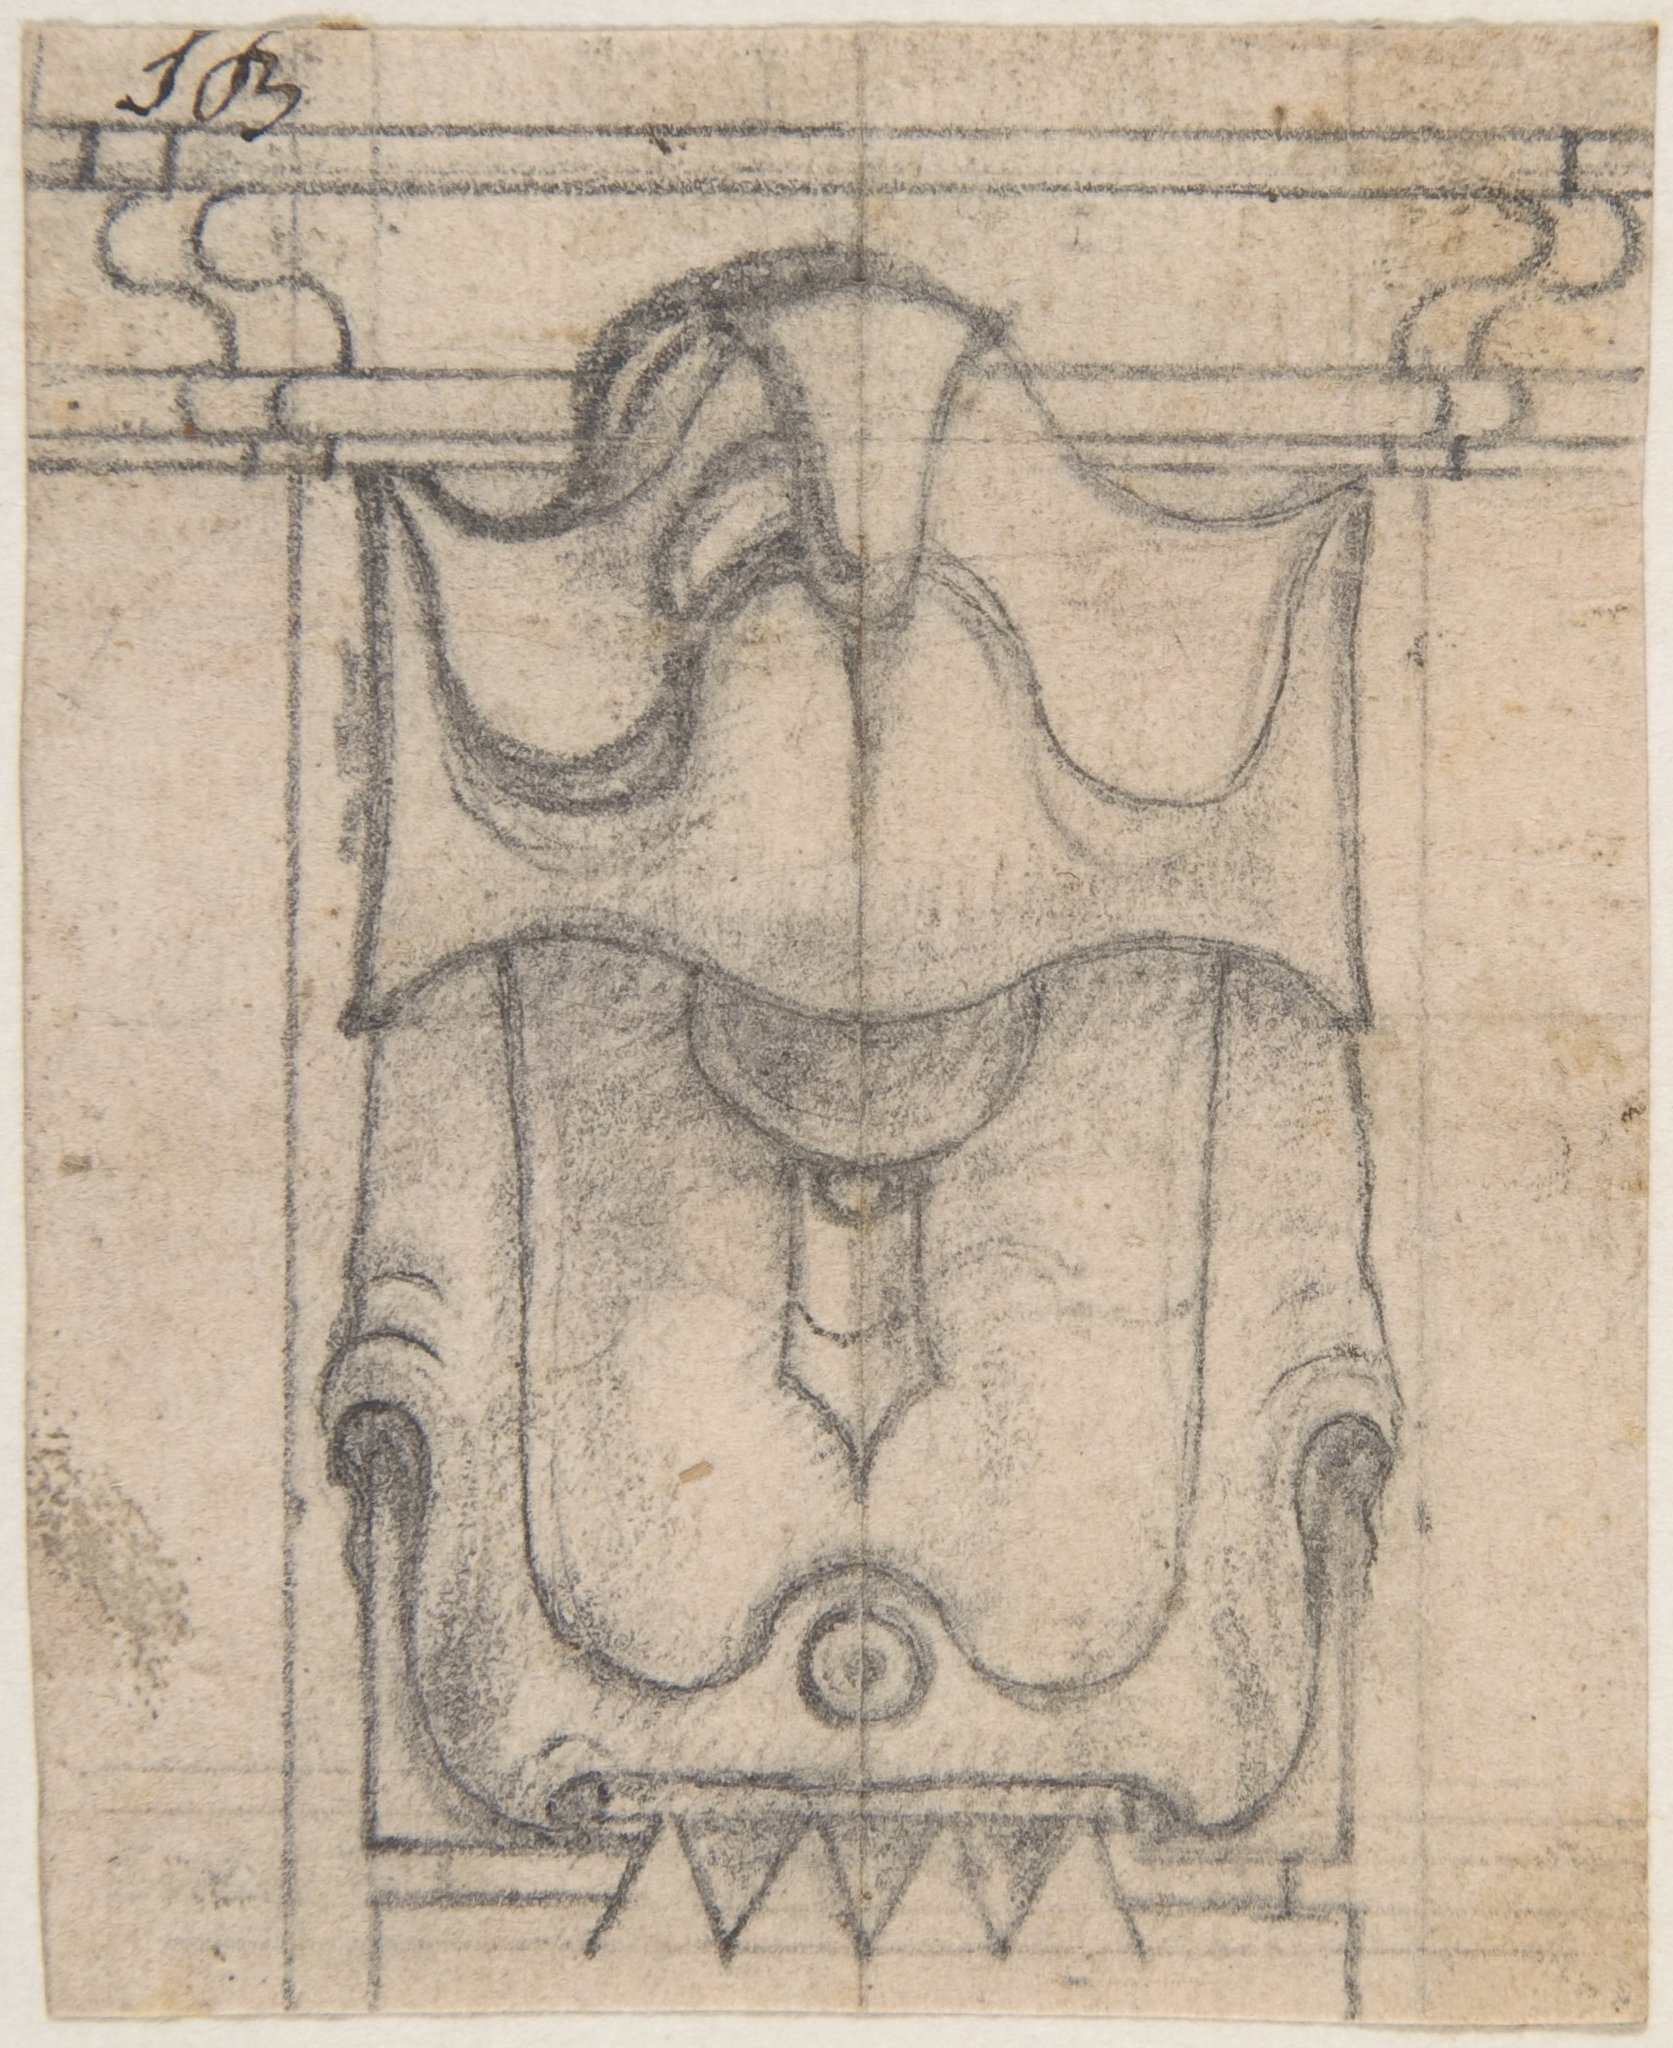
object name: drawing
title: Design for a Coat of Arms Partially Covered in Drapery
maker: giovanni battista foggini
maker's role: artist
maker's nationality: italian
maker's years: 1652-1725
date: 1672-1725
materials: chalk, graphite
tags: coat of arms